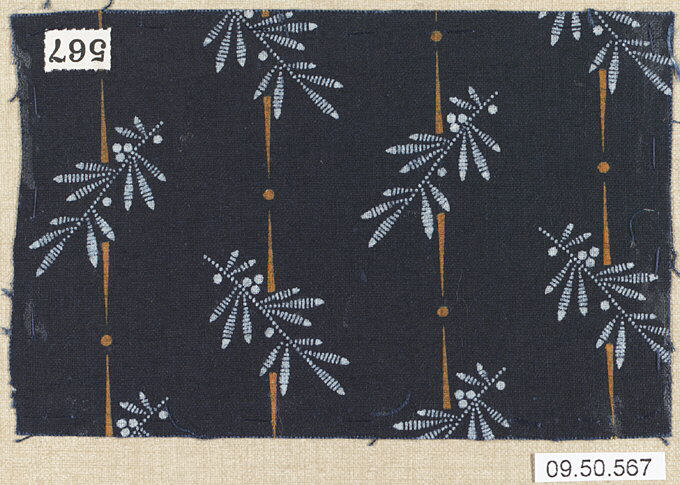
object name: piece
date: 1801-1900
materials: cotton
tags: leaves